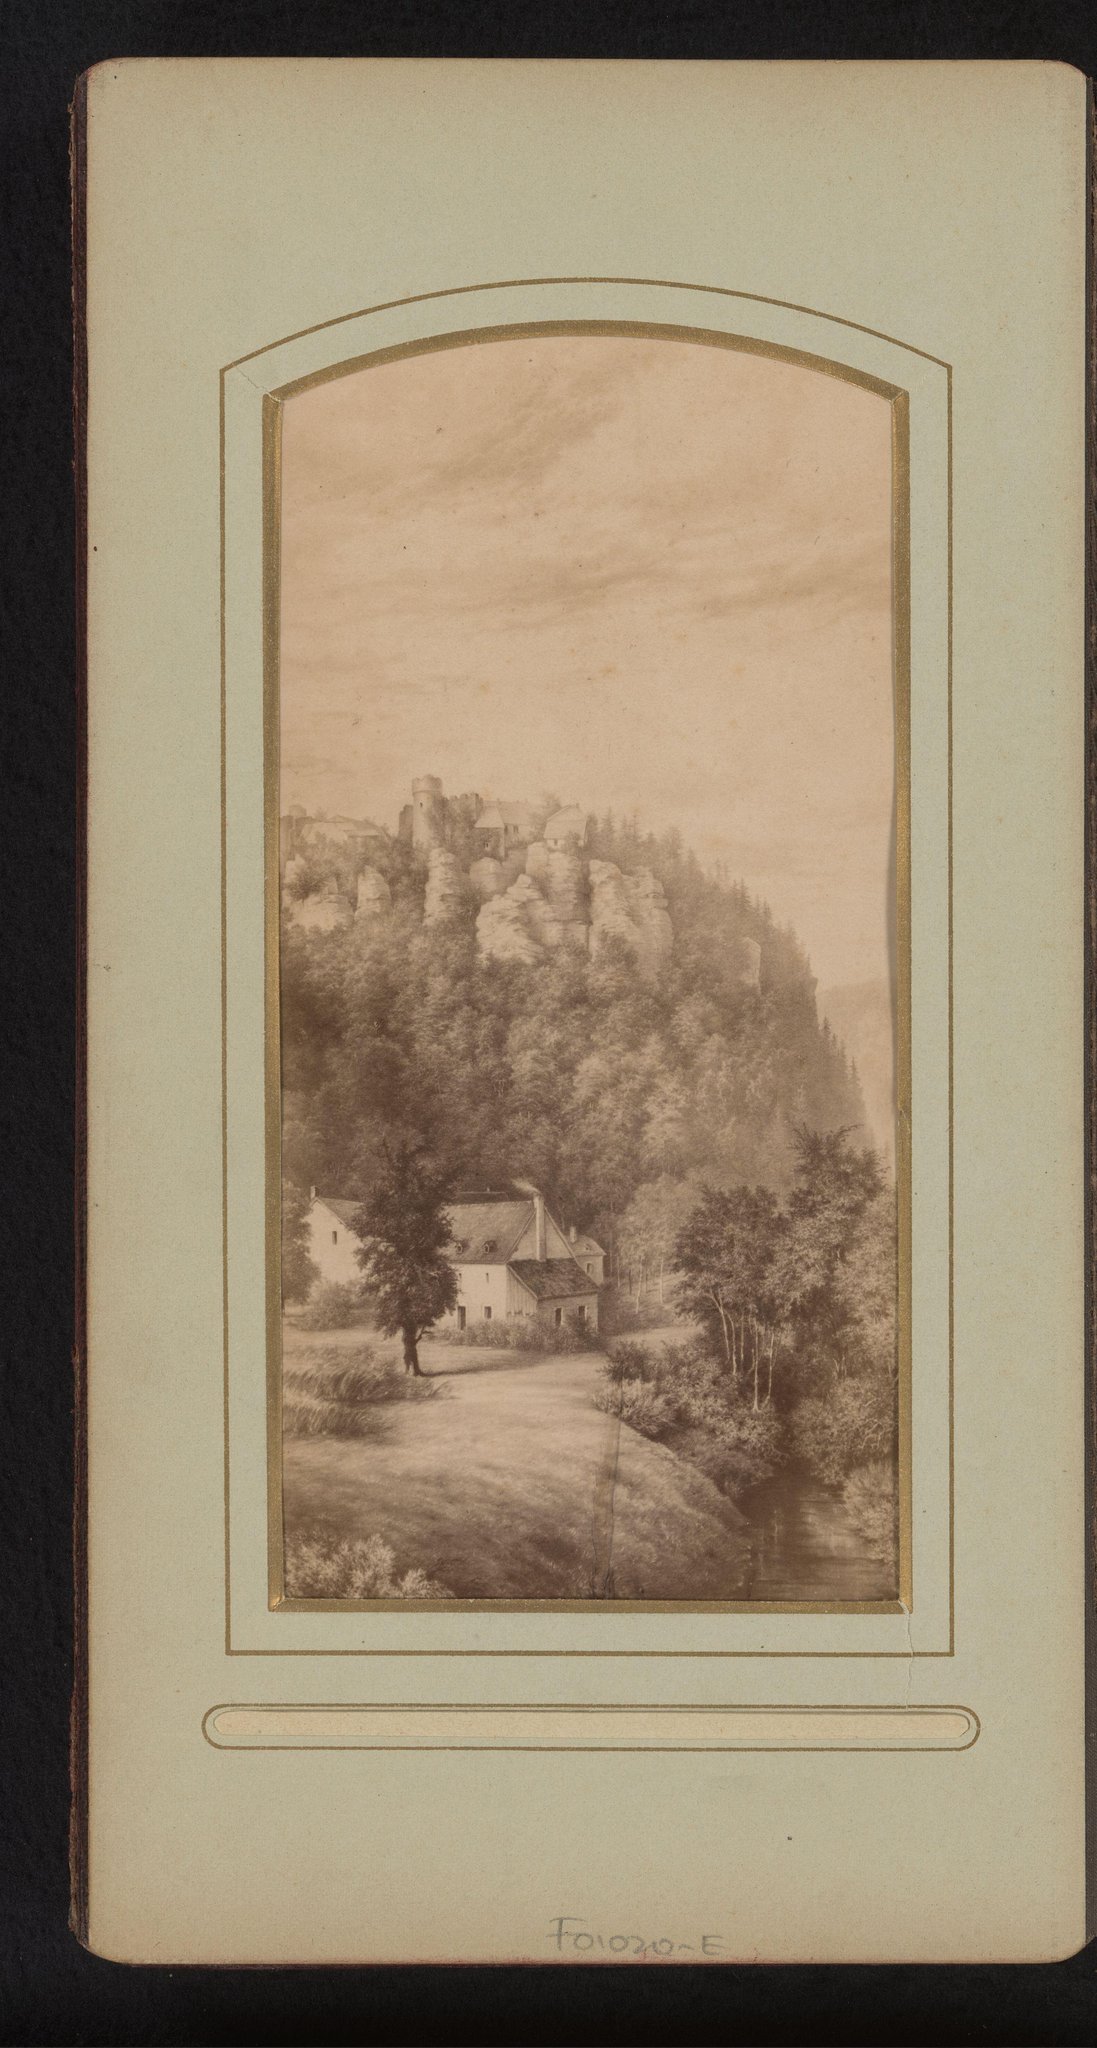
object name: album leaf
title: Fotoreproductie van een prent van een woning tussen de bomen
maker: nicolas maroldt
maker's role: fotograaf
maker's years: 1843-1906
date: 1860-1889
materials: photographic support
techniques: albumen print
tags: trees, the graphic arts, housing